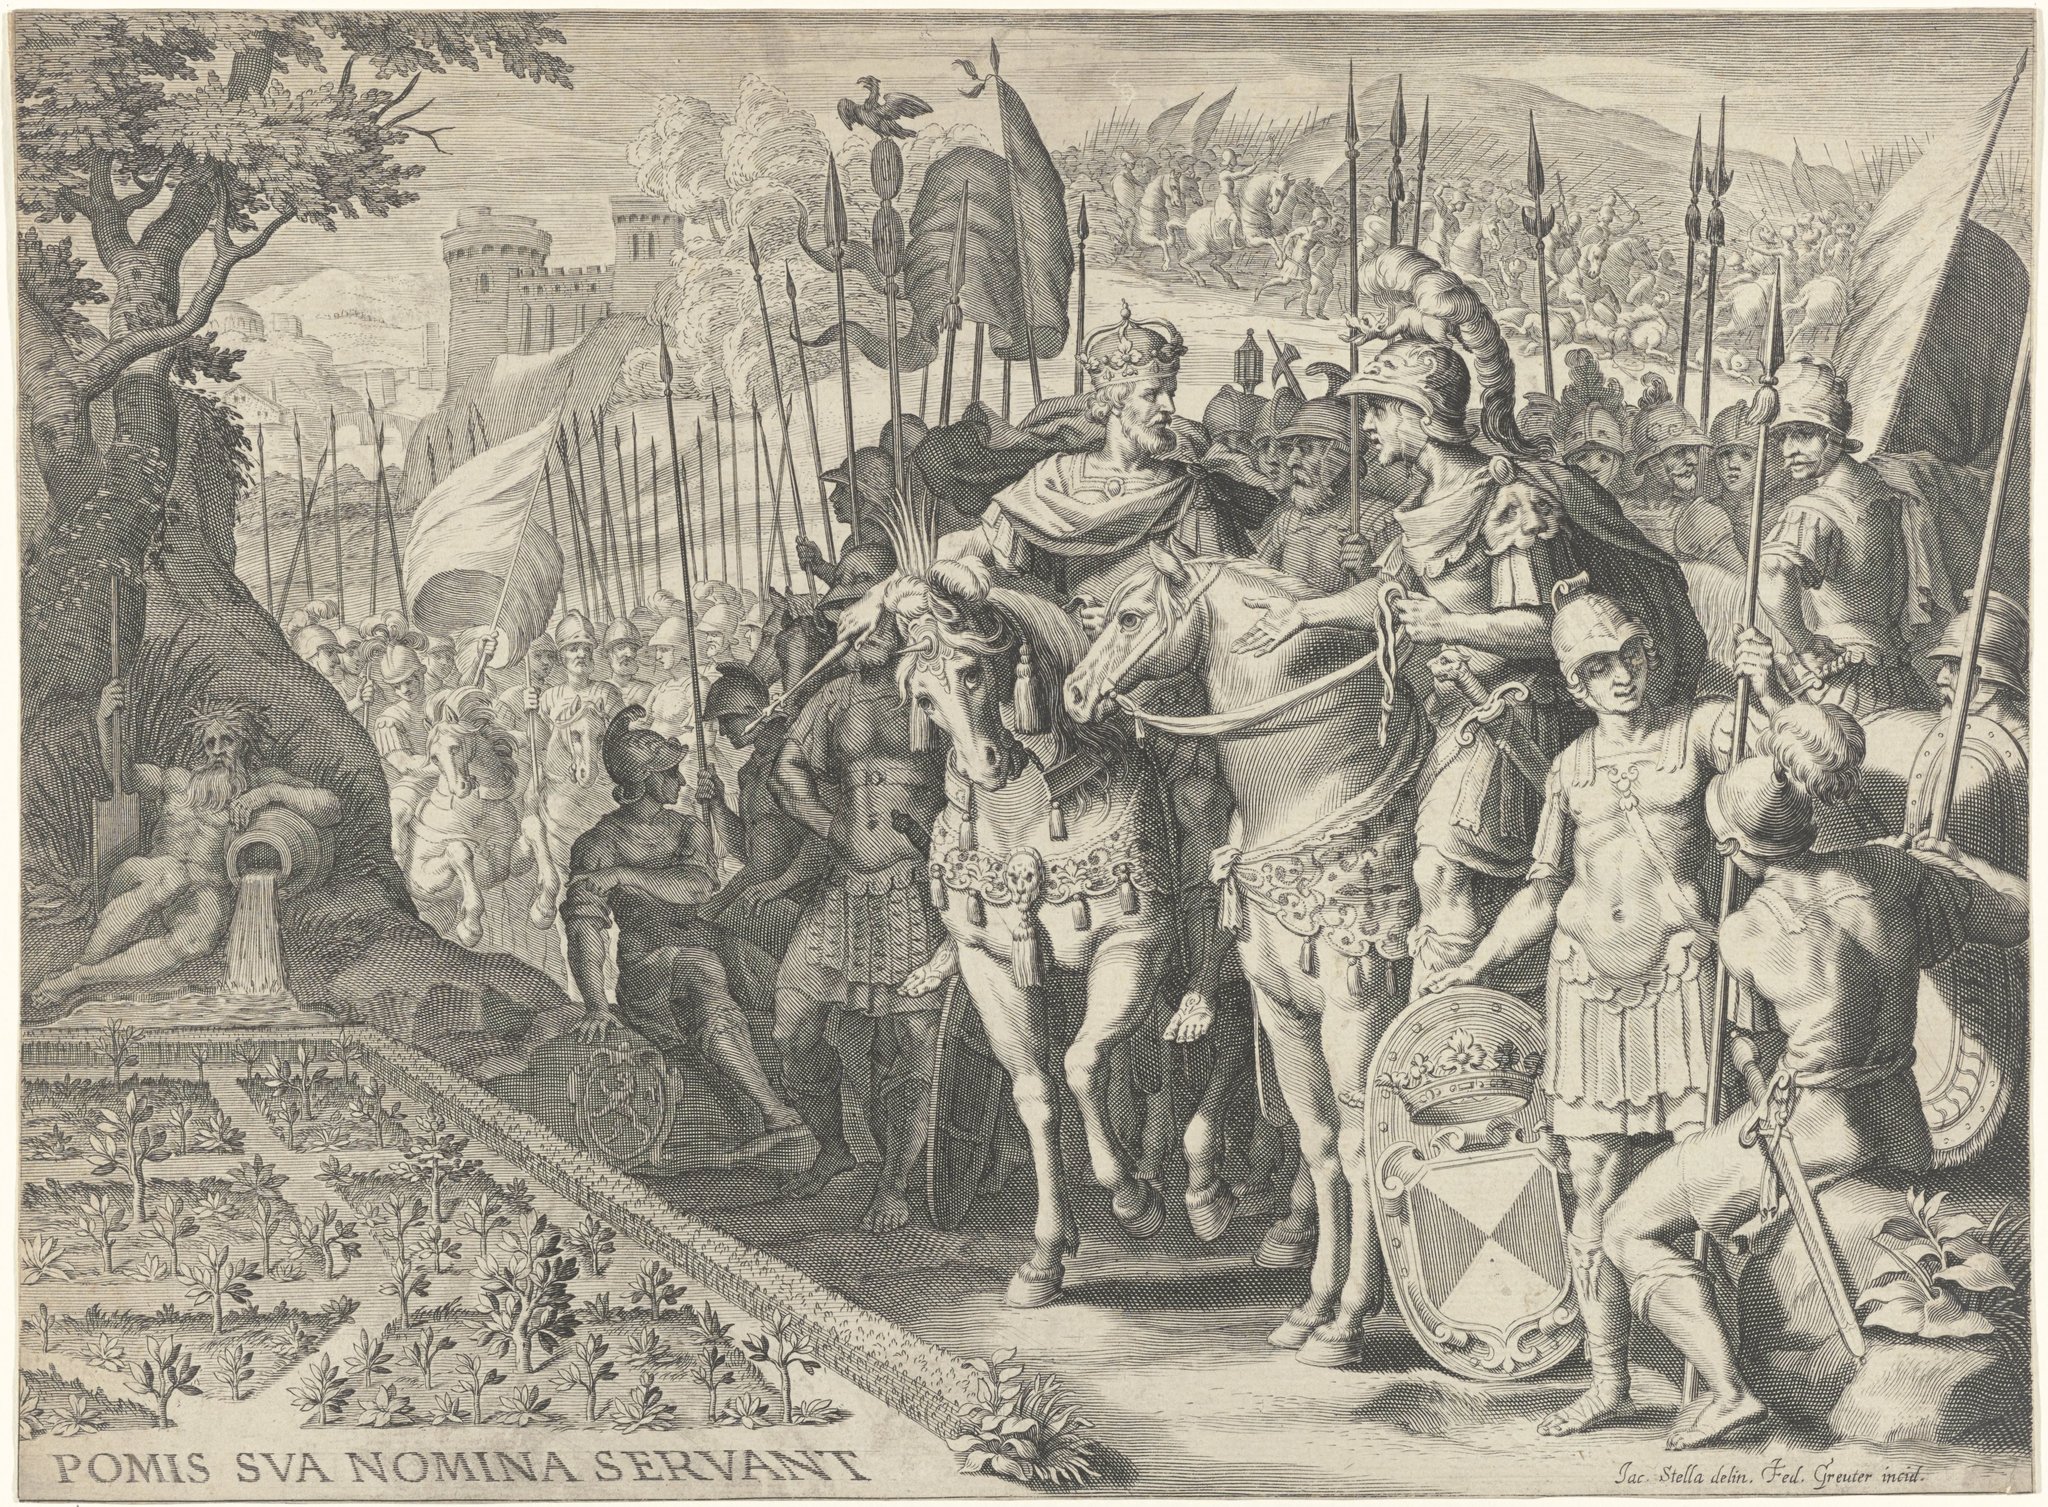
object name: print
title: Keizer en gerenaal gevolgd door een leger bij een tuin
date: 1599-1662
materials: paper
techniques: engraving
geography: italy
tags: garden, battle, warfare; military affairs (+ cavalry, horsemen), the soldier; the soldier's life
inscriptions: collector's mark: Lugt 2228, collector's mark: ‘P. Mariette’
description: Een keizer en een generaal te paard, gevolgd door een leger van voetsoldaten en soldaten te paard. Op de achtergrond soldaten in gevecht. Op de voorgrond een tuin met de tekst: Pomis sua nomina servant.